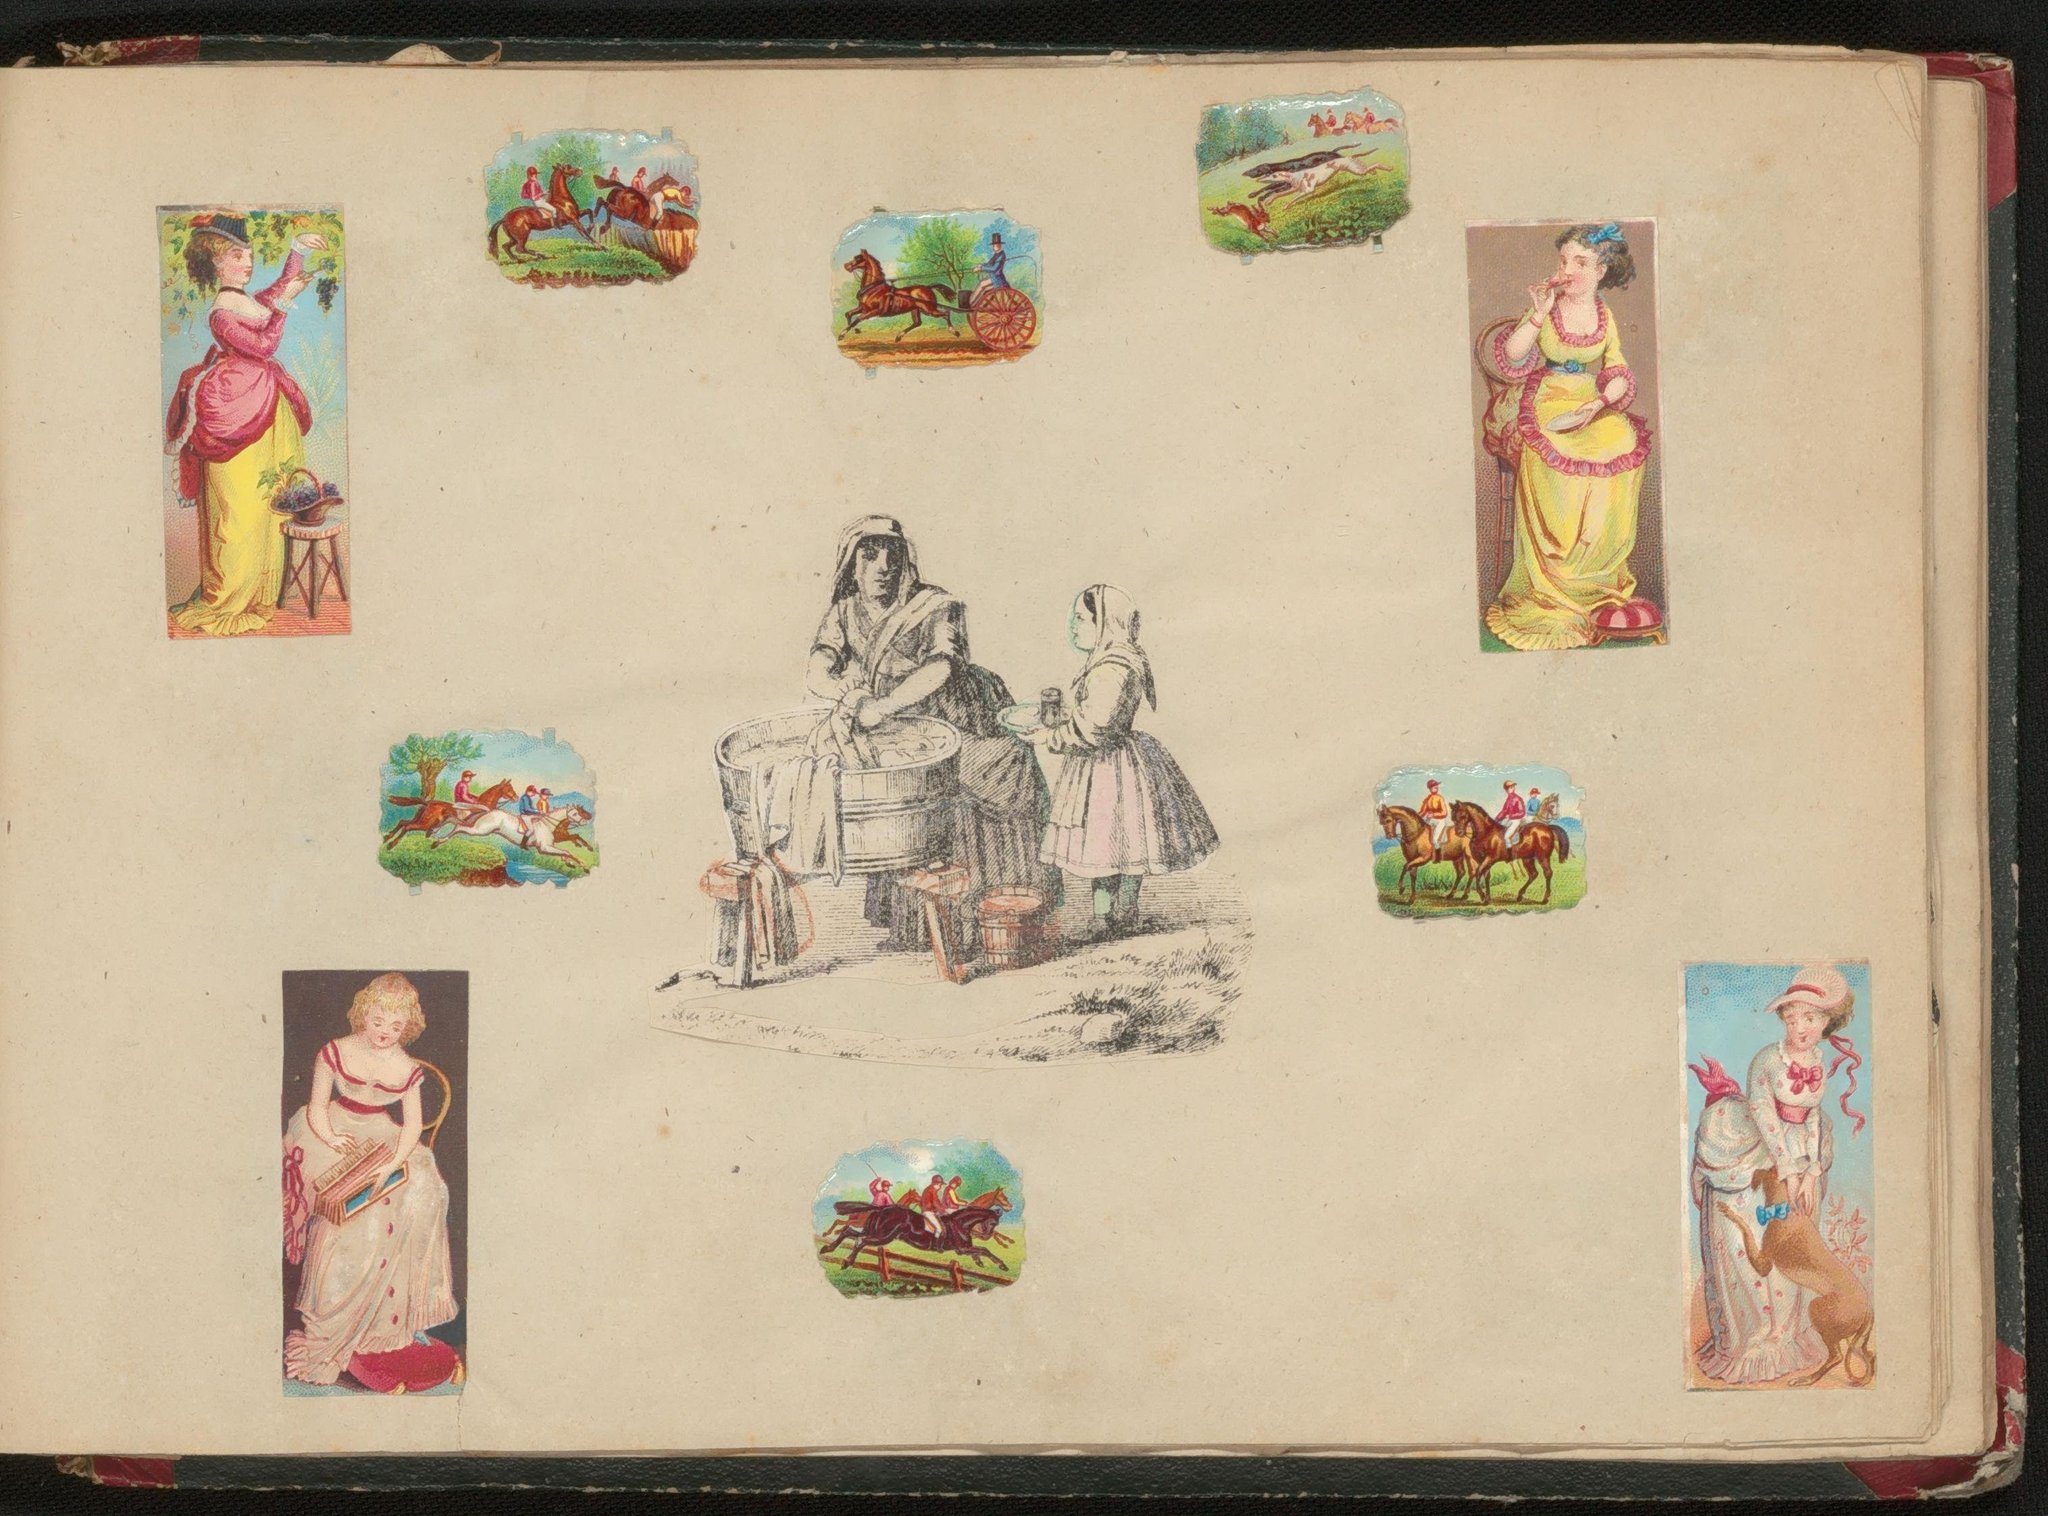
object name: album leaf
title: Albumblad met 10 plakplaatjes en een prentfragment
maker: Anonymous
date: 1880-1910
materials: paper, watercolor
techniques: chromolithography, hand coloring, lithograph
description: Albumblad met 10 plakplaatjes en een ingeplakte uitgeknipte fragment van een prent. Onderdeel van het plakboek met 38 bladen gevuld met plakplaatjes, poesieplaatjes en uitgeknipte en ingeplakte fragmenten van prenten. Onderwerpsrubrieken binnen de Atlas Zeden en Gewoonten: Schoone kunsten, Varia.